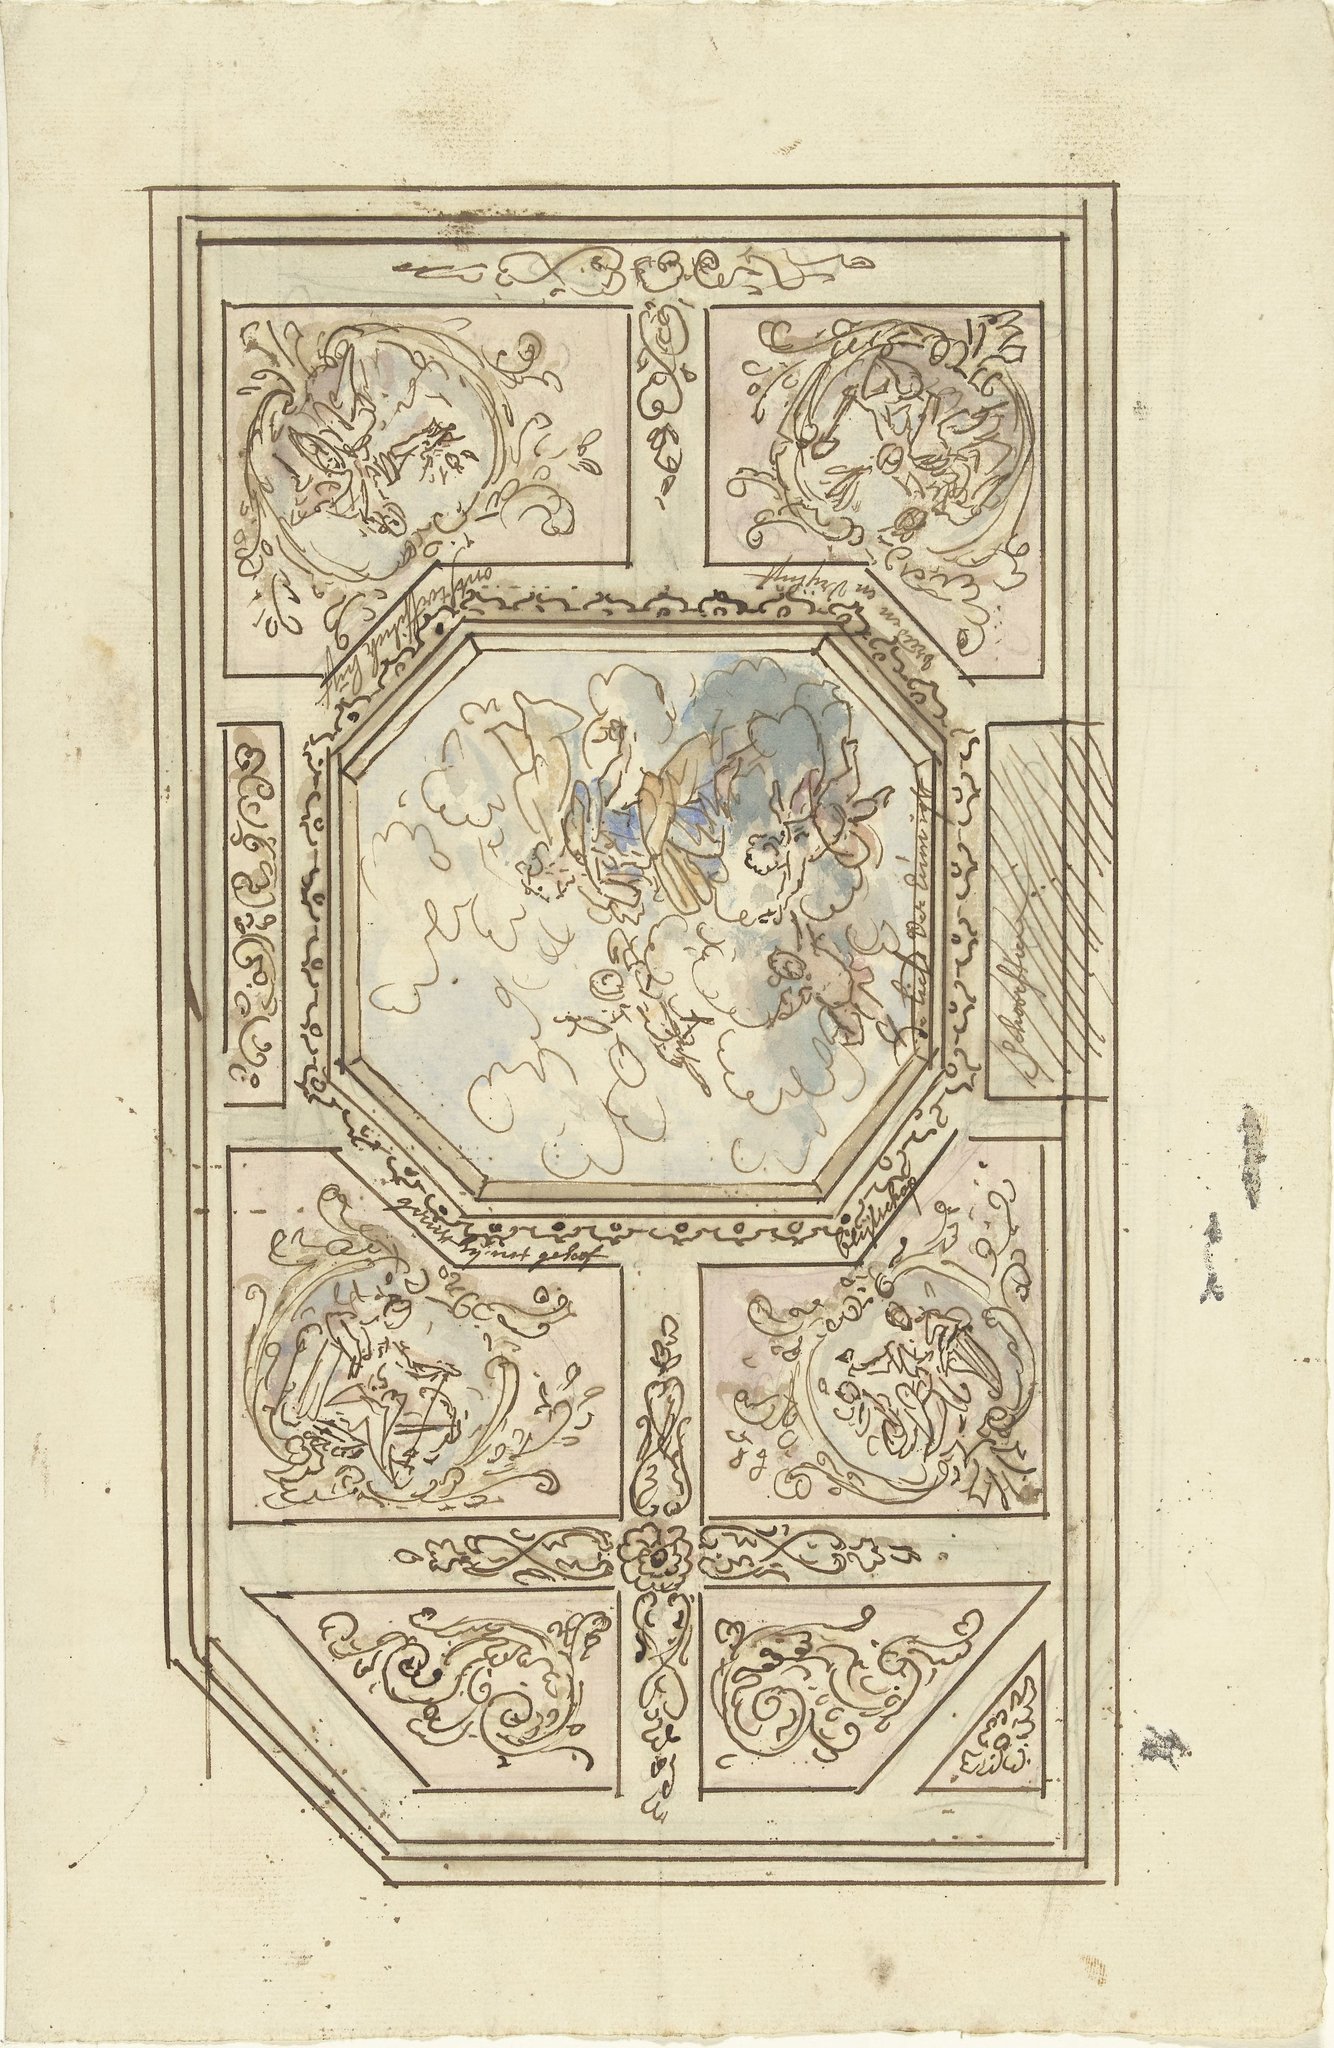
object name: design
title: Ontwerp voor een plafondschildering met apotheose van Liefde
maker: elias van nijmegen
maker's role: draughtsman, painter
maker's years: 1667-1755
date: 1677-1755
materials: ink, paper, pencil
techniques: brush, pen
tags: (personifications and symbolic representations of) love; 'amore (secondo seneca)' (ripa) (+ abstract concept represented by female figure), (decorated) ceiling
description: Ontwerp voor een plafondschildering: apotheose van Liefde, in de andere vakken allegorische vrouwenfiguren.